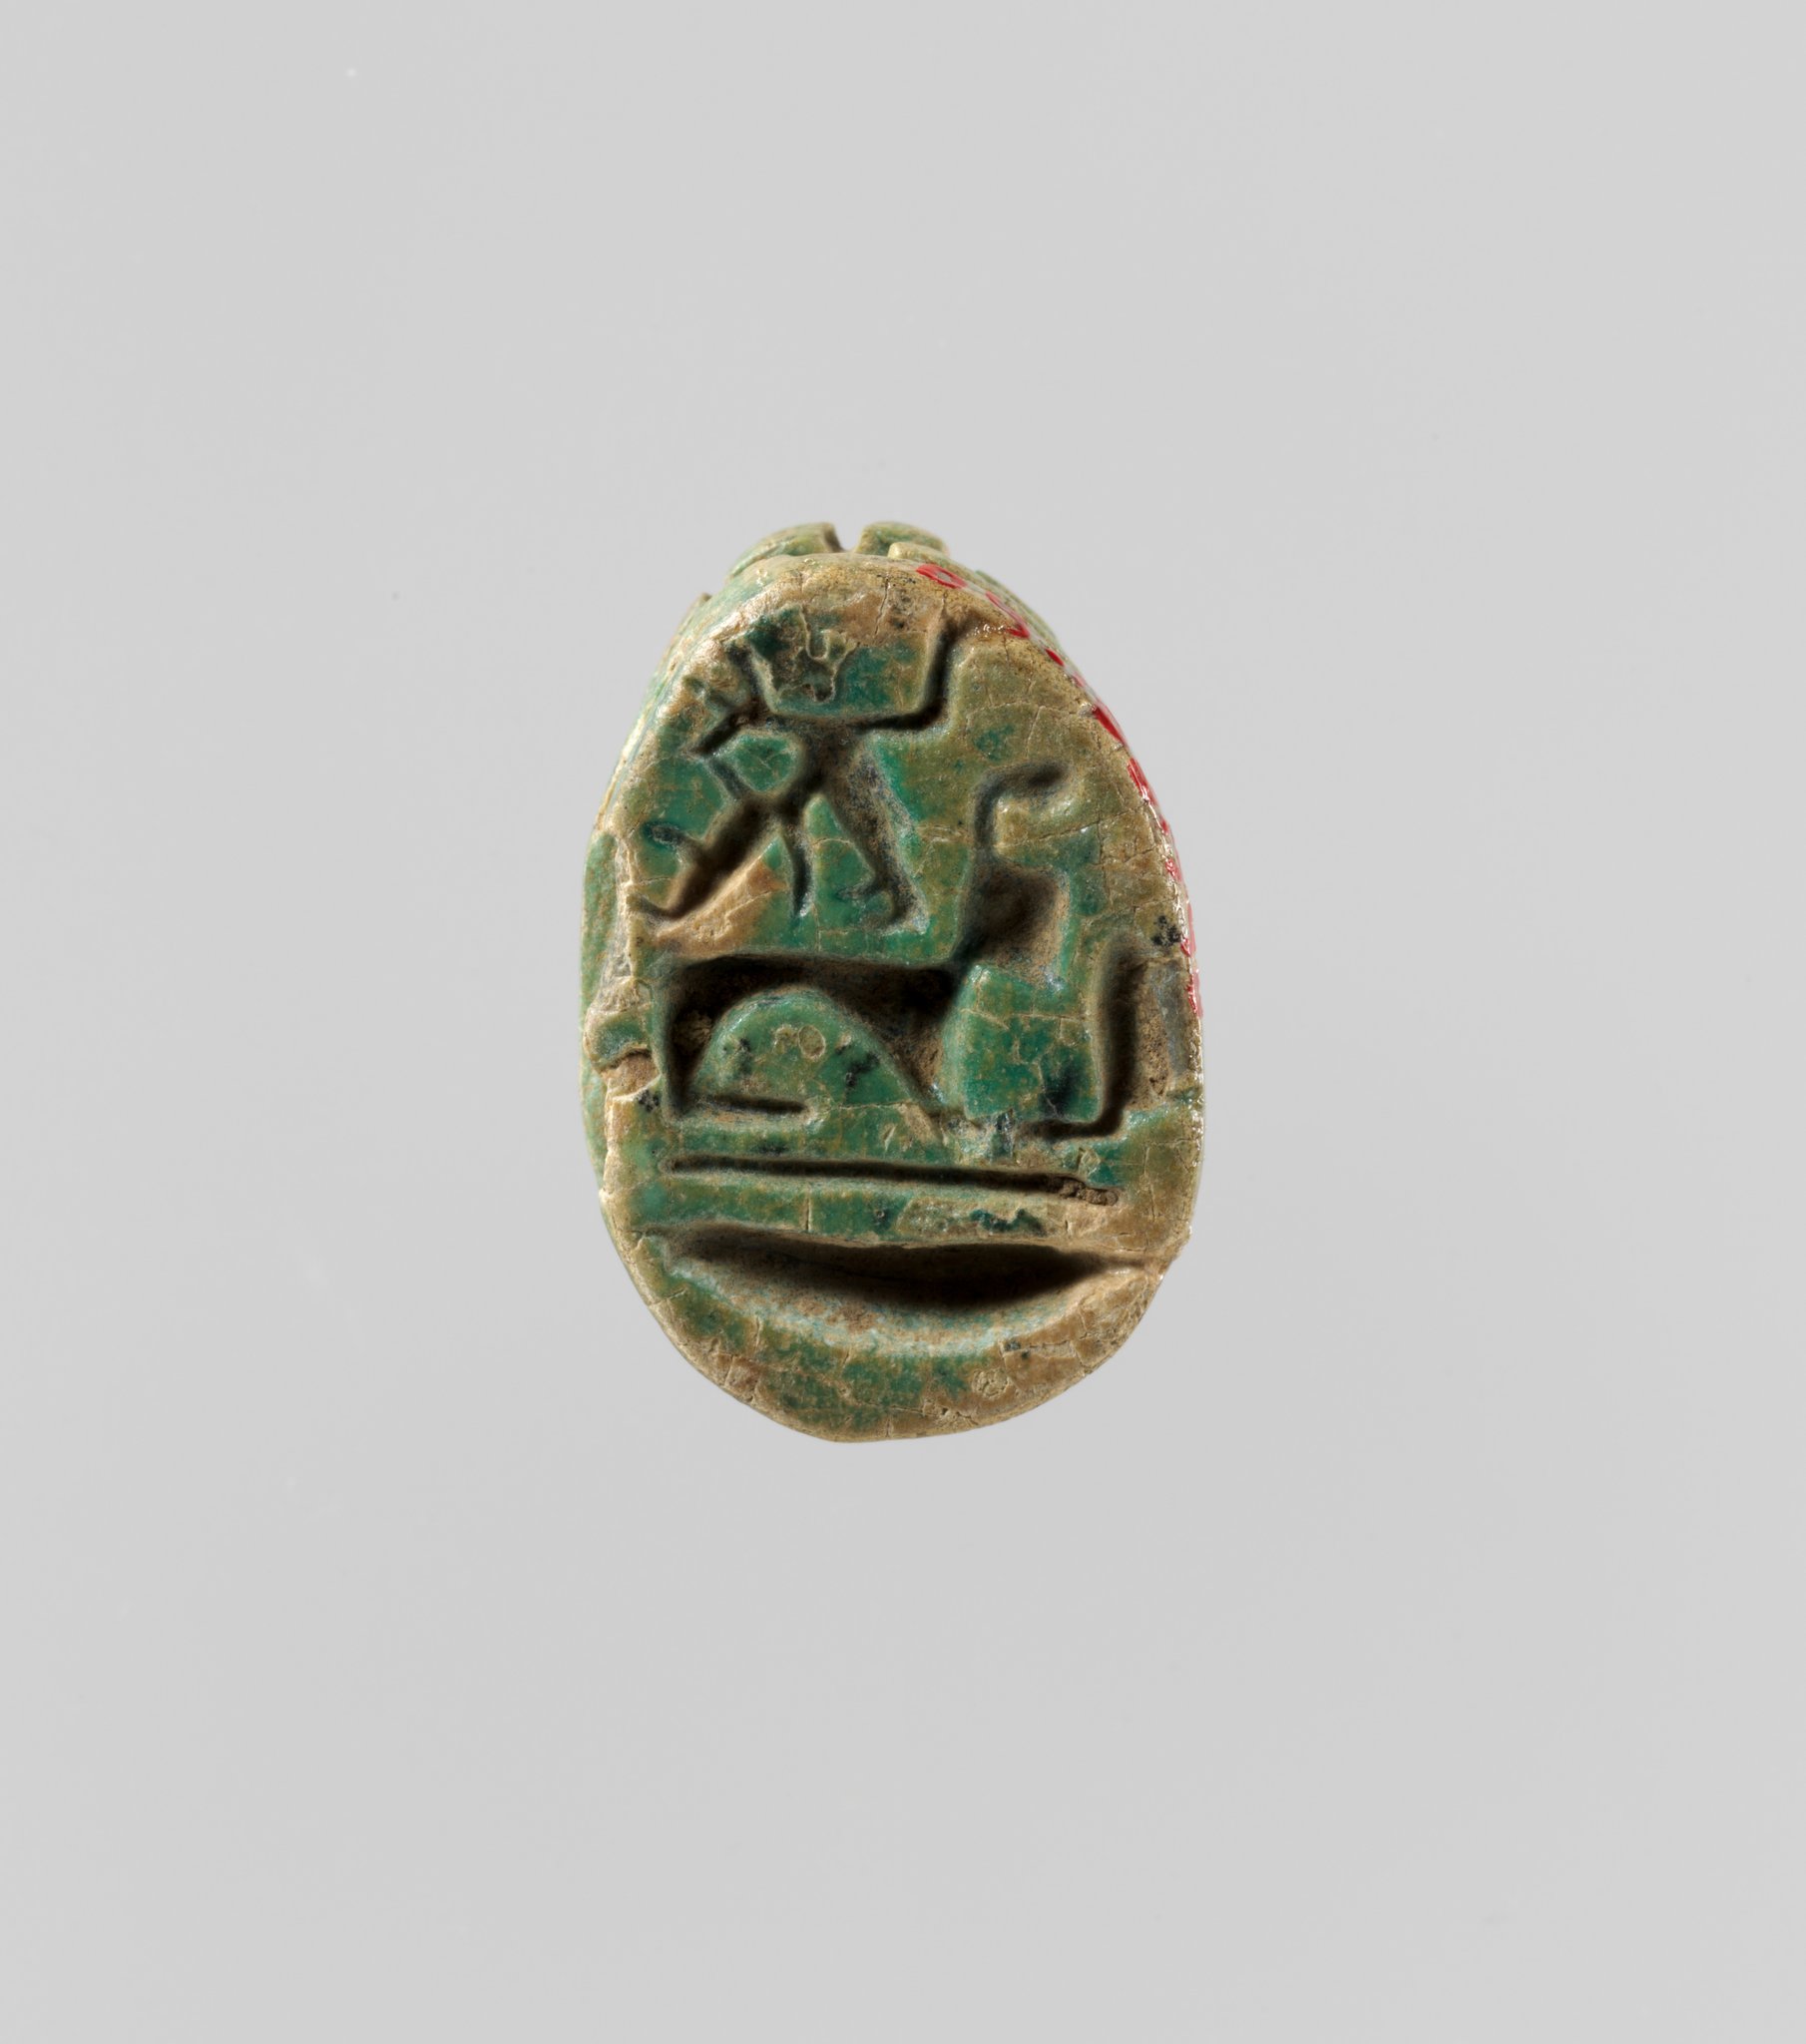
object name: scarab, sphinx, uraeus, vulture or winged cobra, nb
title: Scarab with the Representation of a Sphinx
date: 1186-945 BCE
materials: stone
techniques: glazing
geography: egypt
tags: sphinx